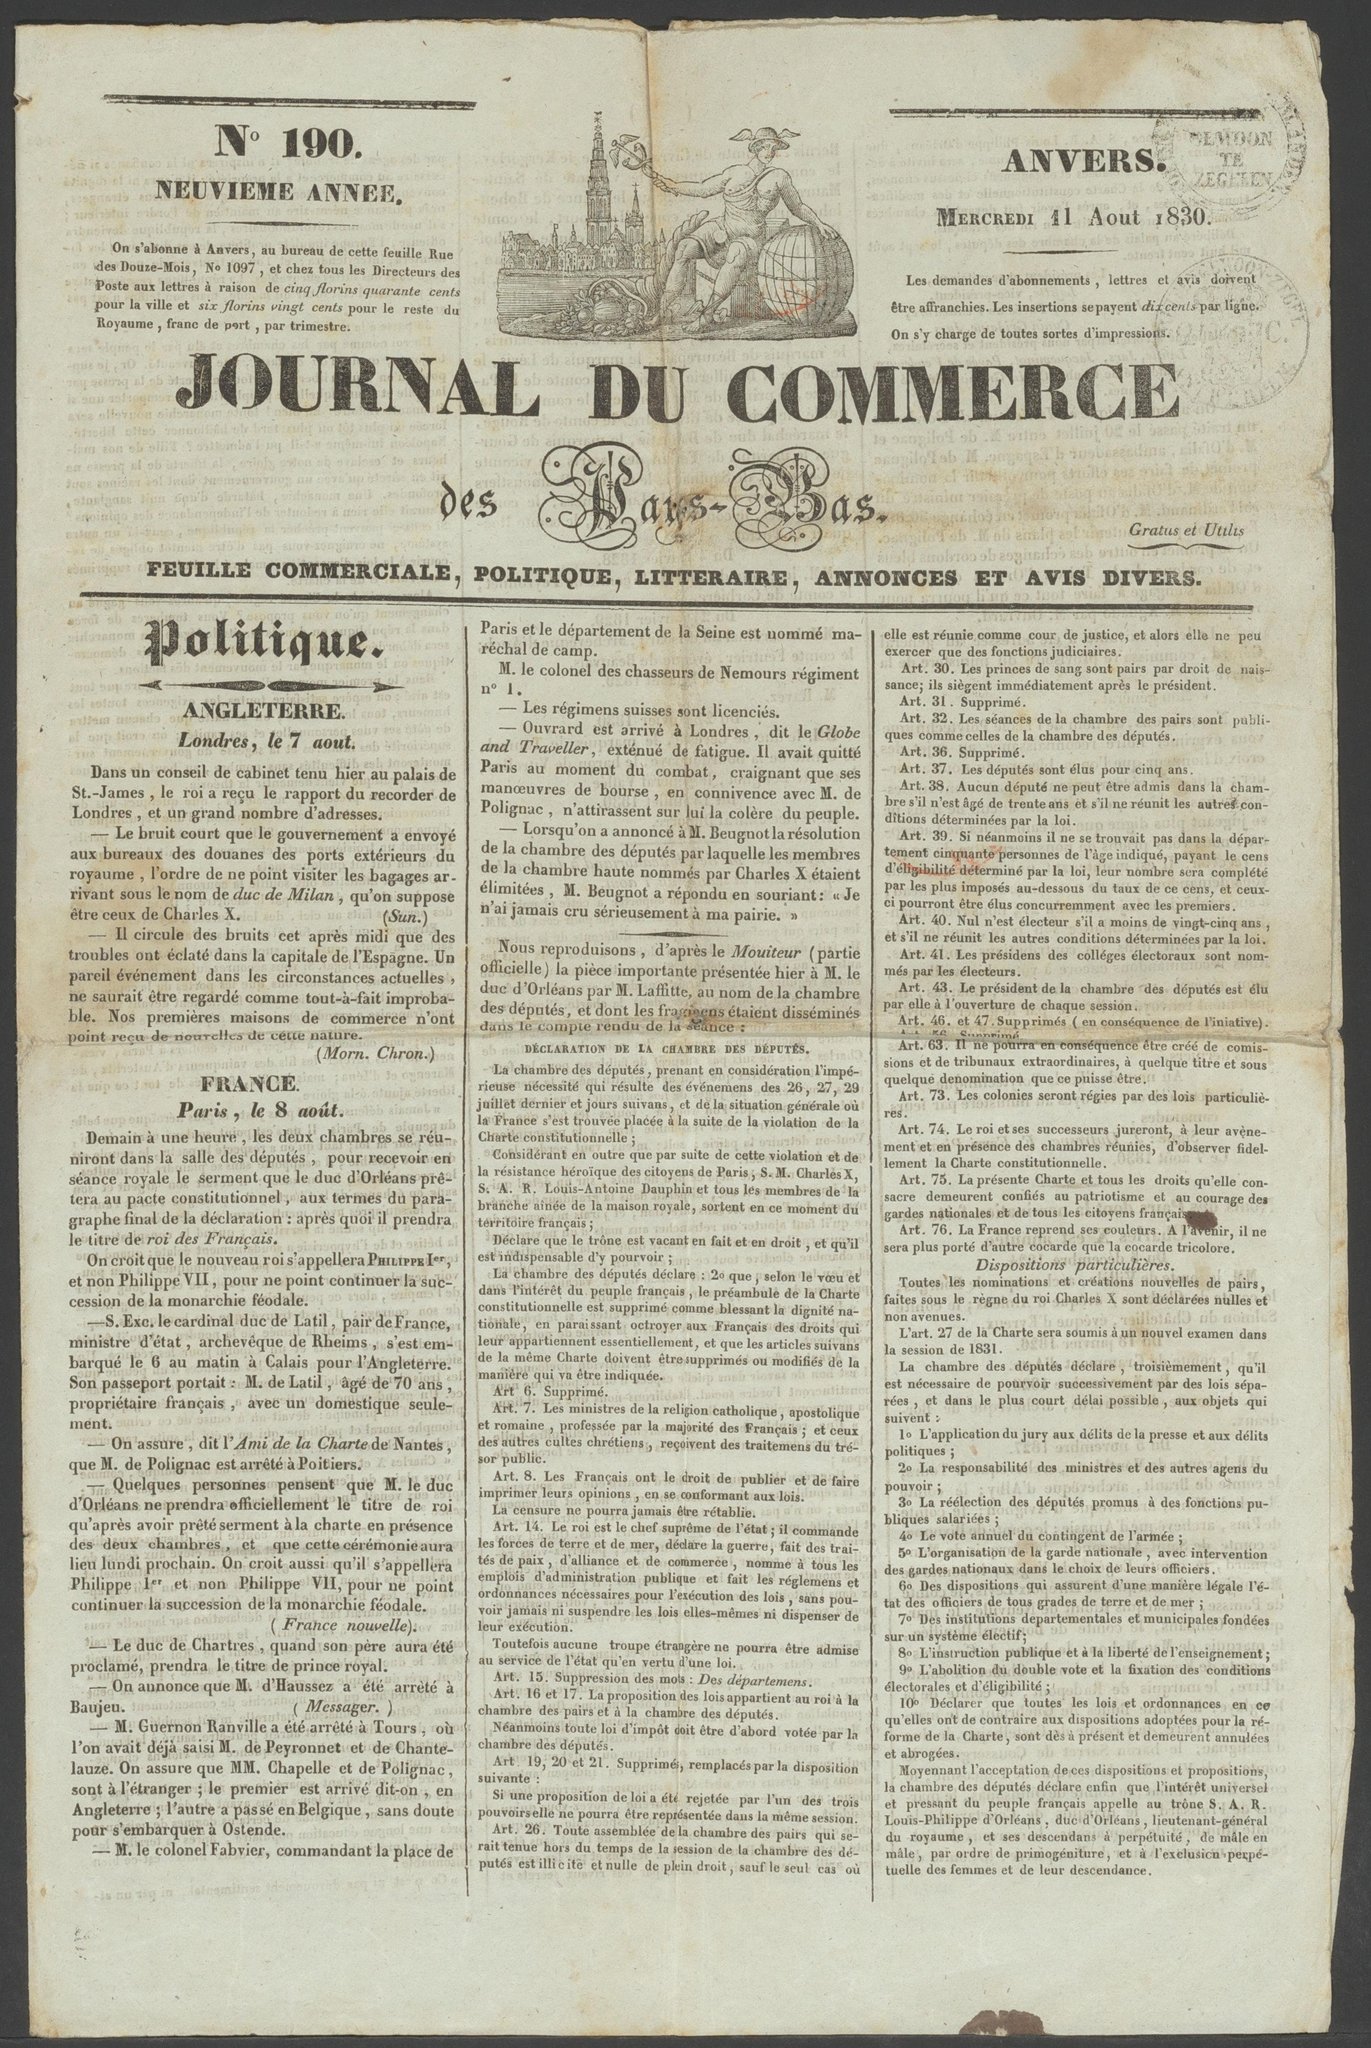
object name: newspaper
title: Journal du Commerce des Pays-Bas, 11 augustus 1830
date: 1830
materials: paper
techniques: letterpress printing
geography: antwerp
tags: newspaper, news-sheet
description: Exemplaar van de krant 'Journal du Commerce des Pays-Bas' van 11 augustus 1830. Dubbelbladig, alle zijden bedrukt. Bovenaan een vignet met Mercurius. Rechtsboven twee stempels vaan betaalde accijnzen. Onderwerpsrubrieken binnen de Atlas Zeden en Gewoonten: Regeering, Officieele Nieuwsbladen.